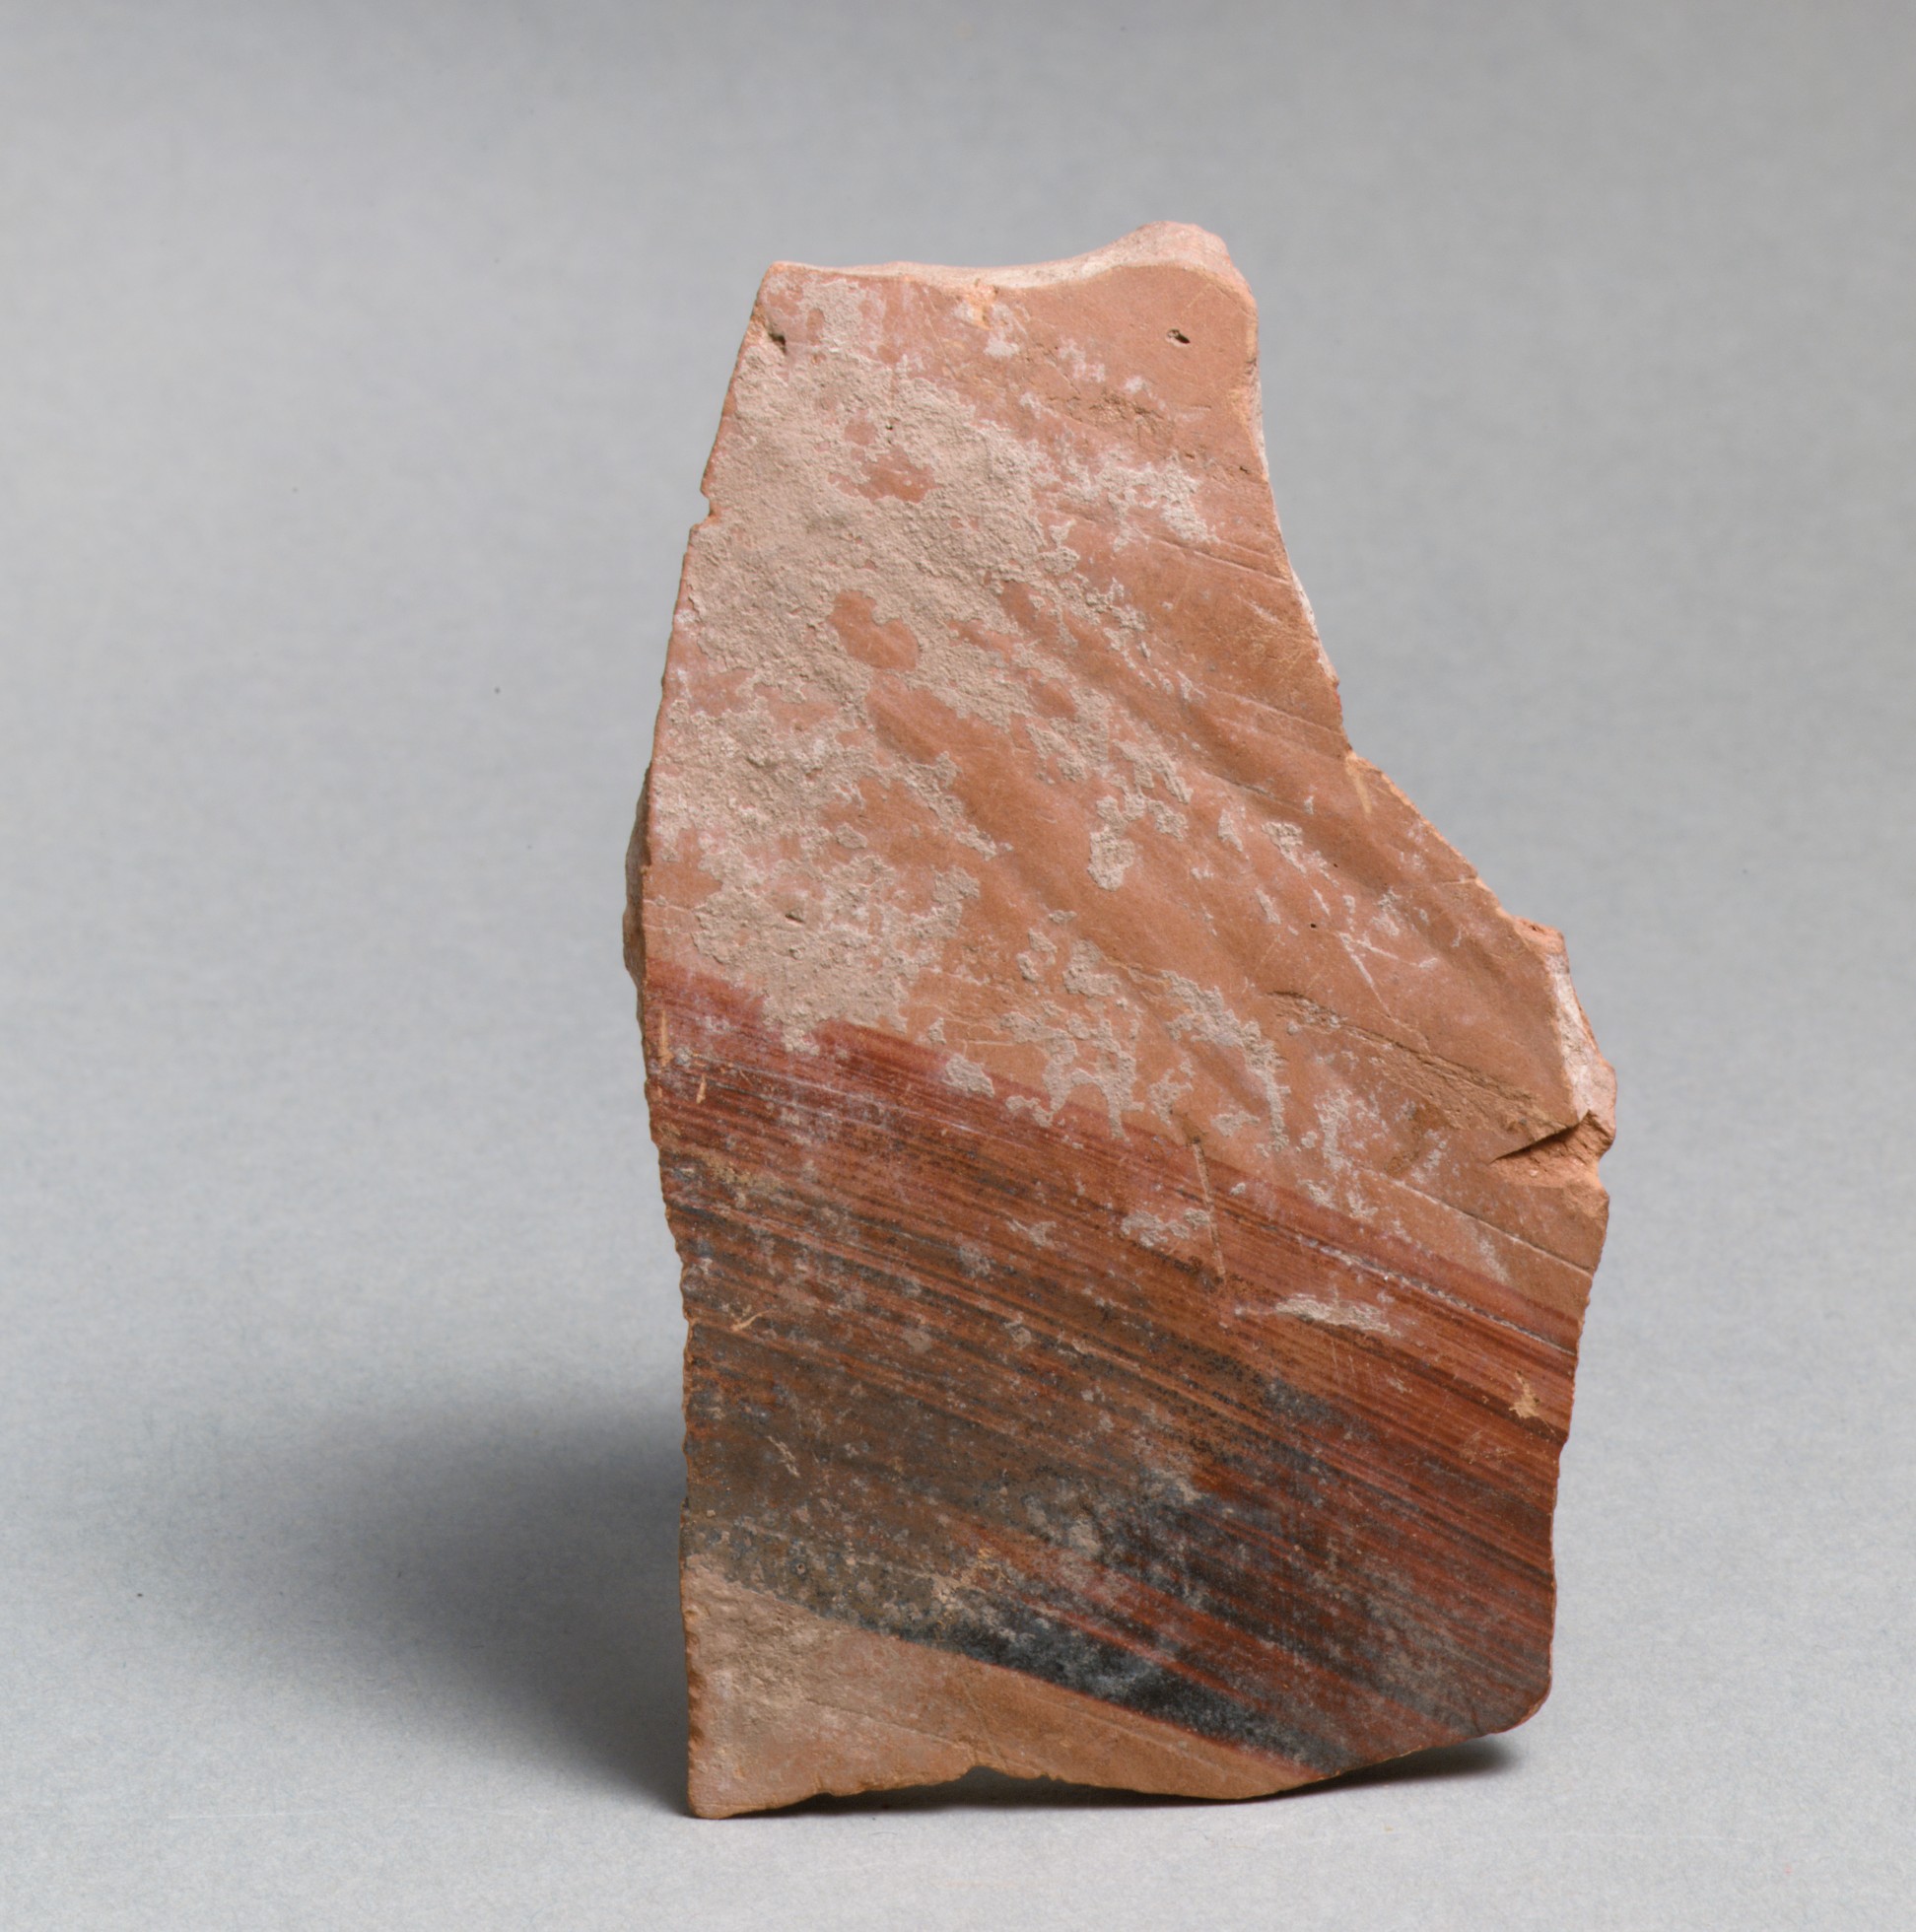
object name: vase fragment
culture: greek or lydian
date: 900-30 BCE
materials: terracotta